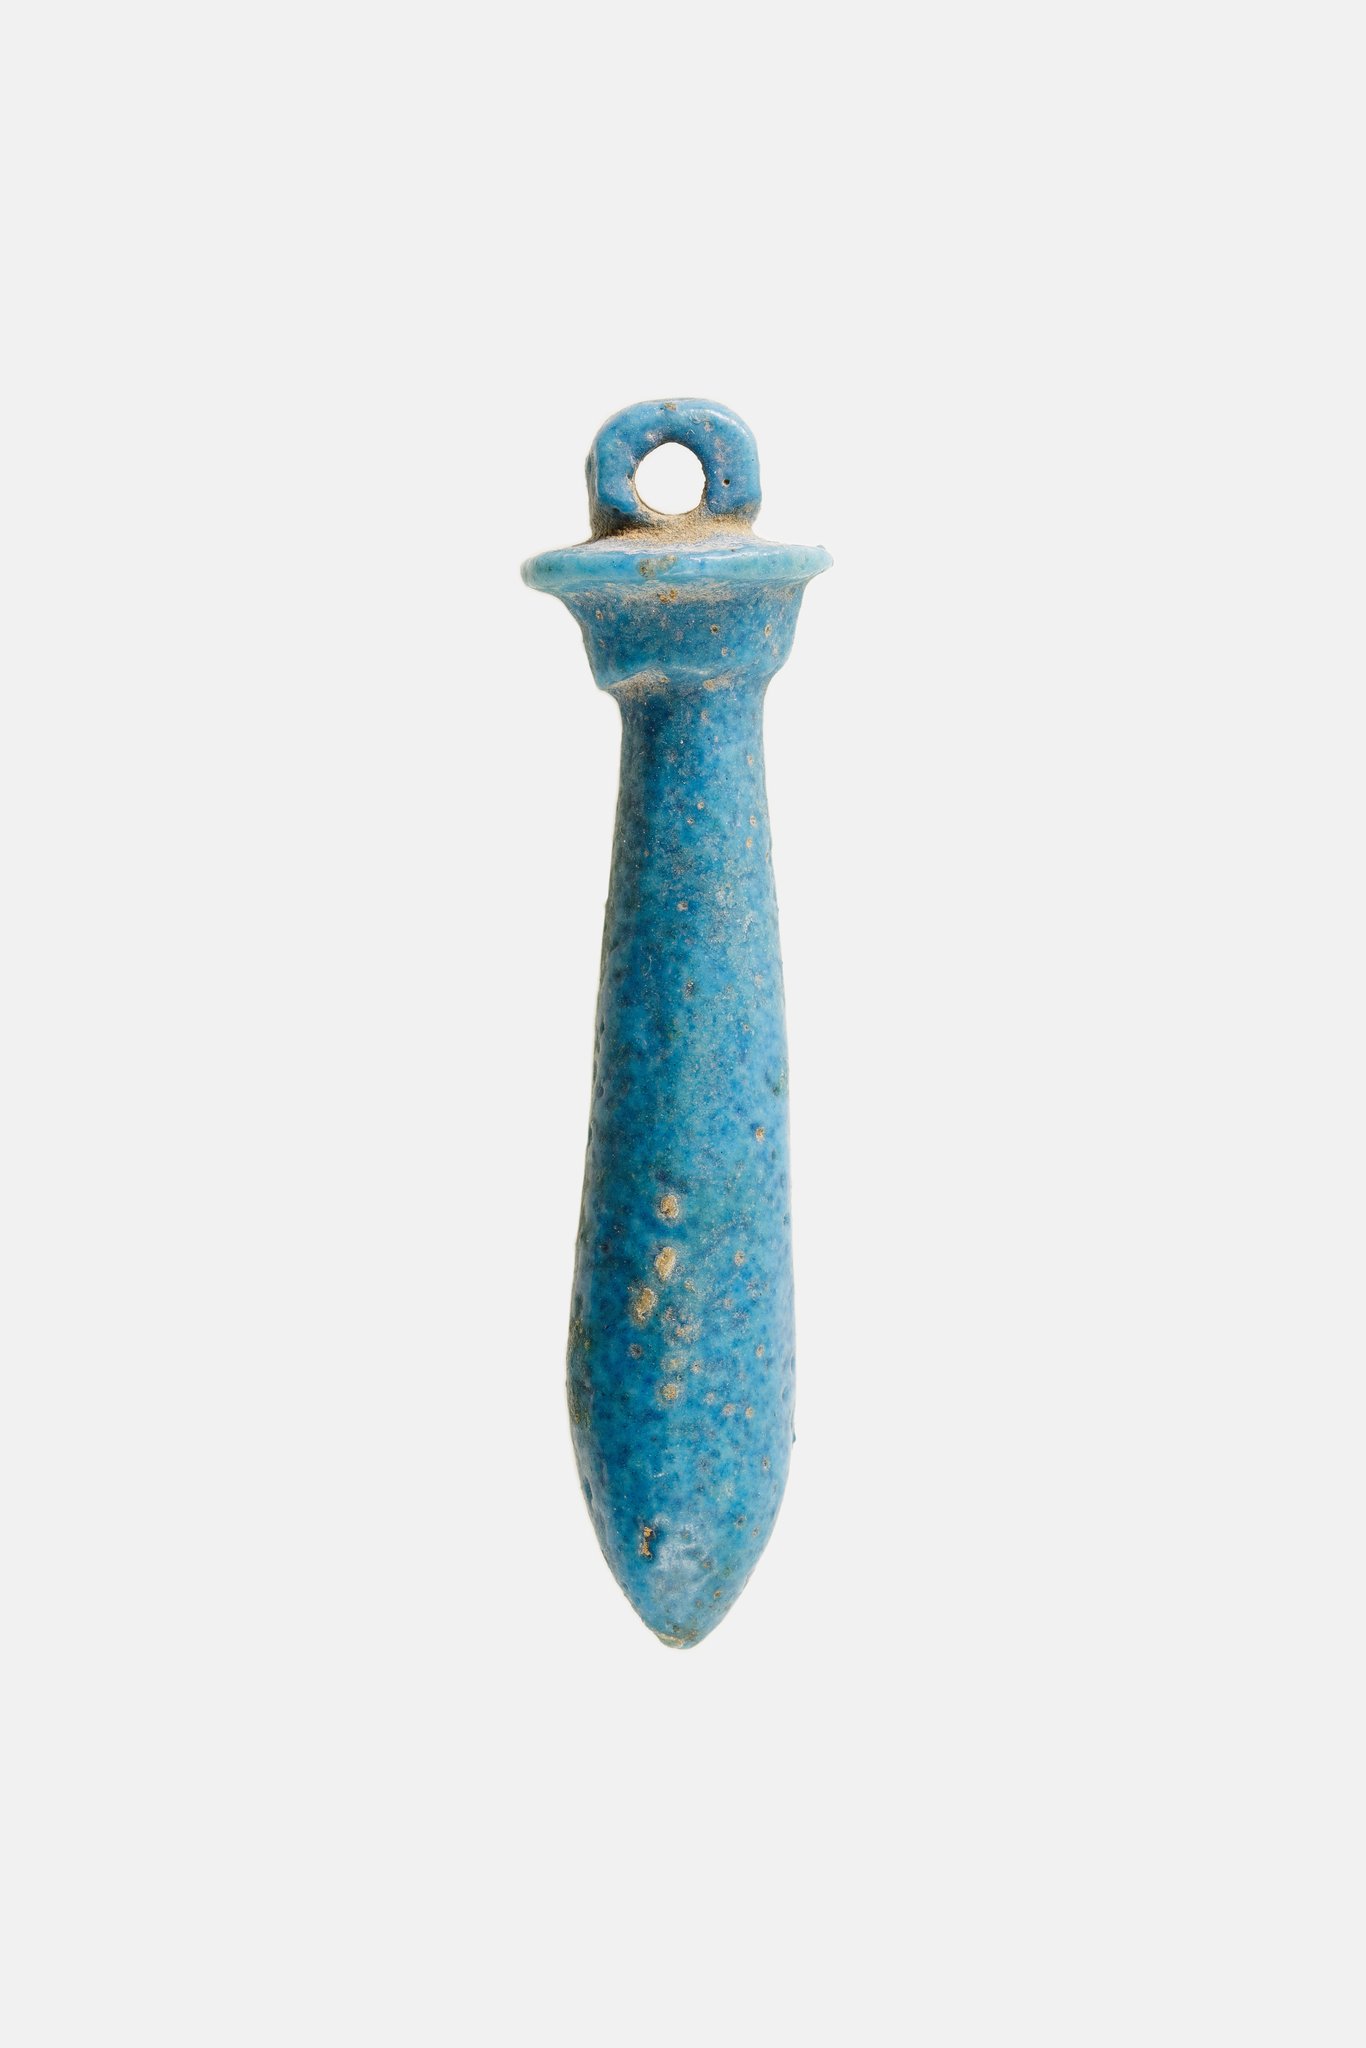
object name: amulet, papyrus scepter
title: Papyrus Scepter (wadj) amulet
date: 712-332 BCE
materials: faience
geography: egypt